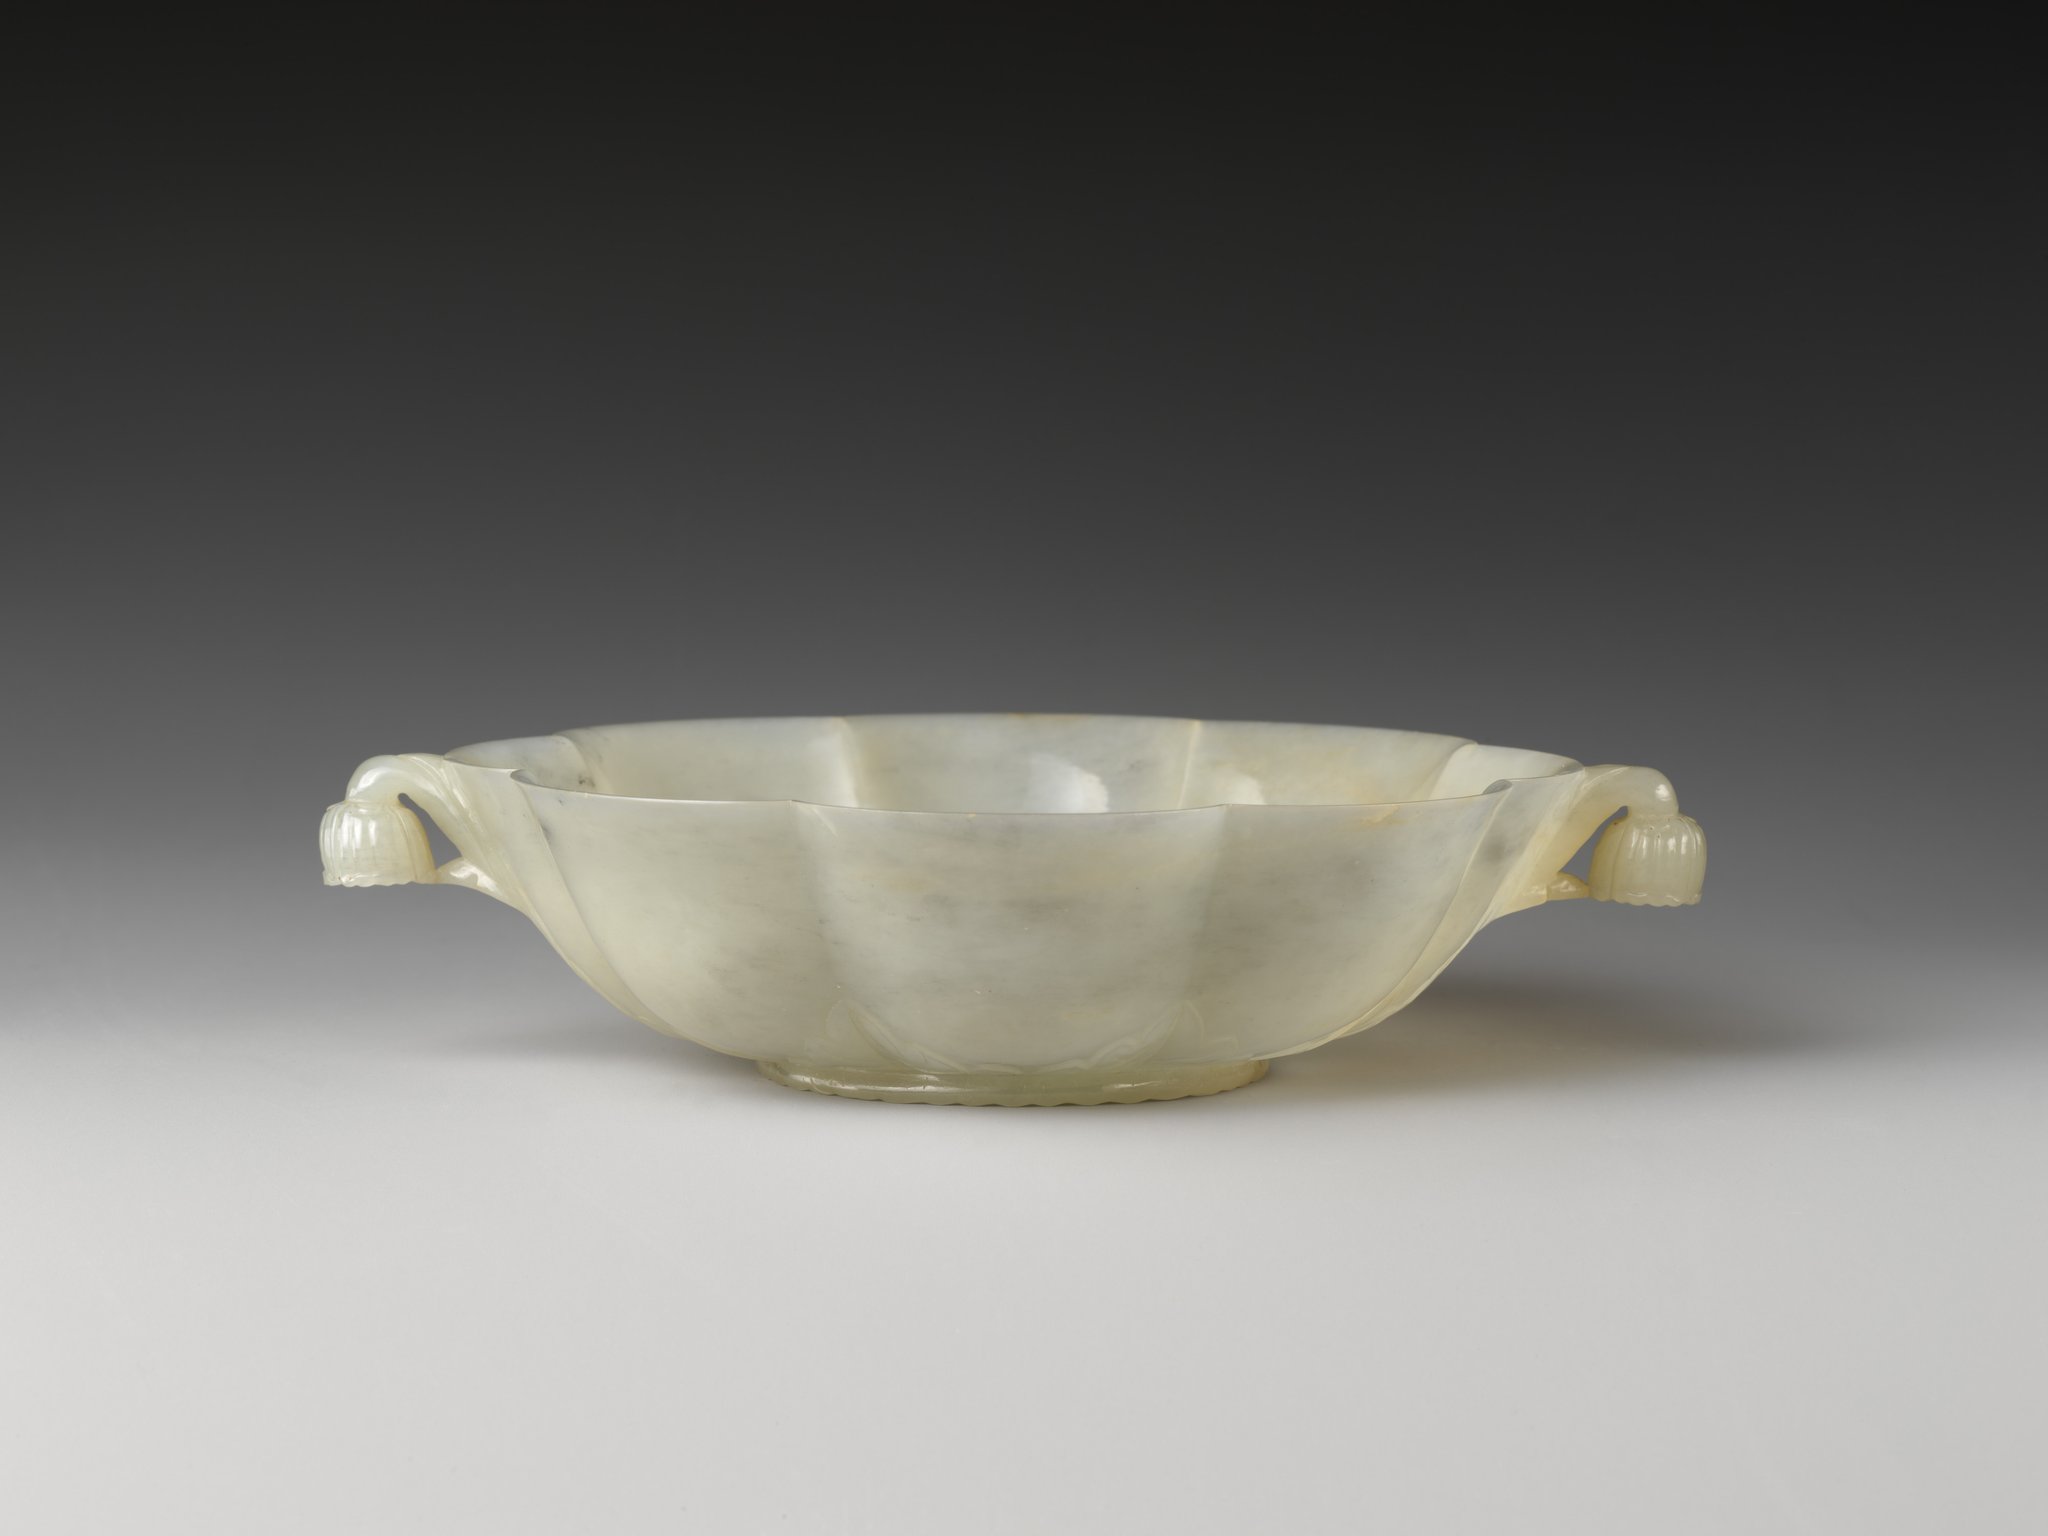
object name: bowl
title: Bowl with lotus design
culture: chinese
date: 1701-1800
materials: jade